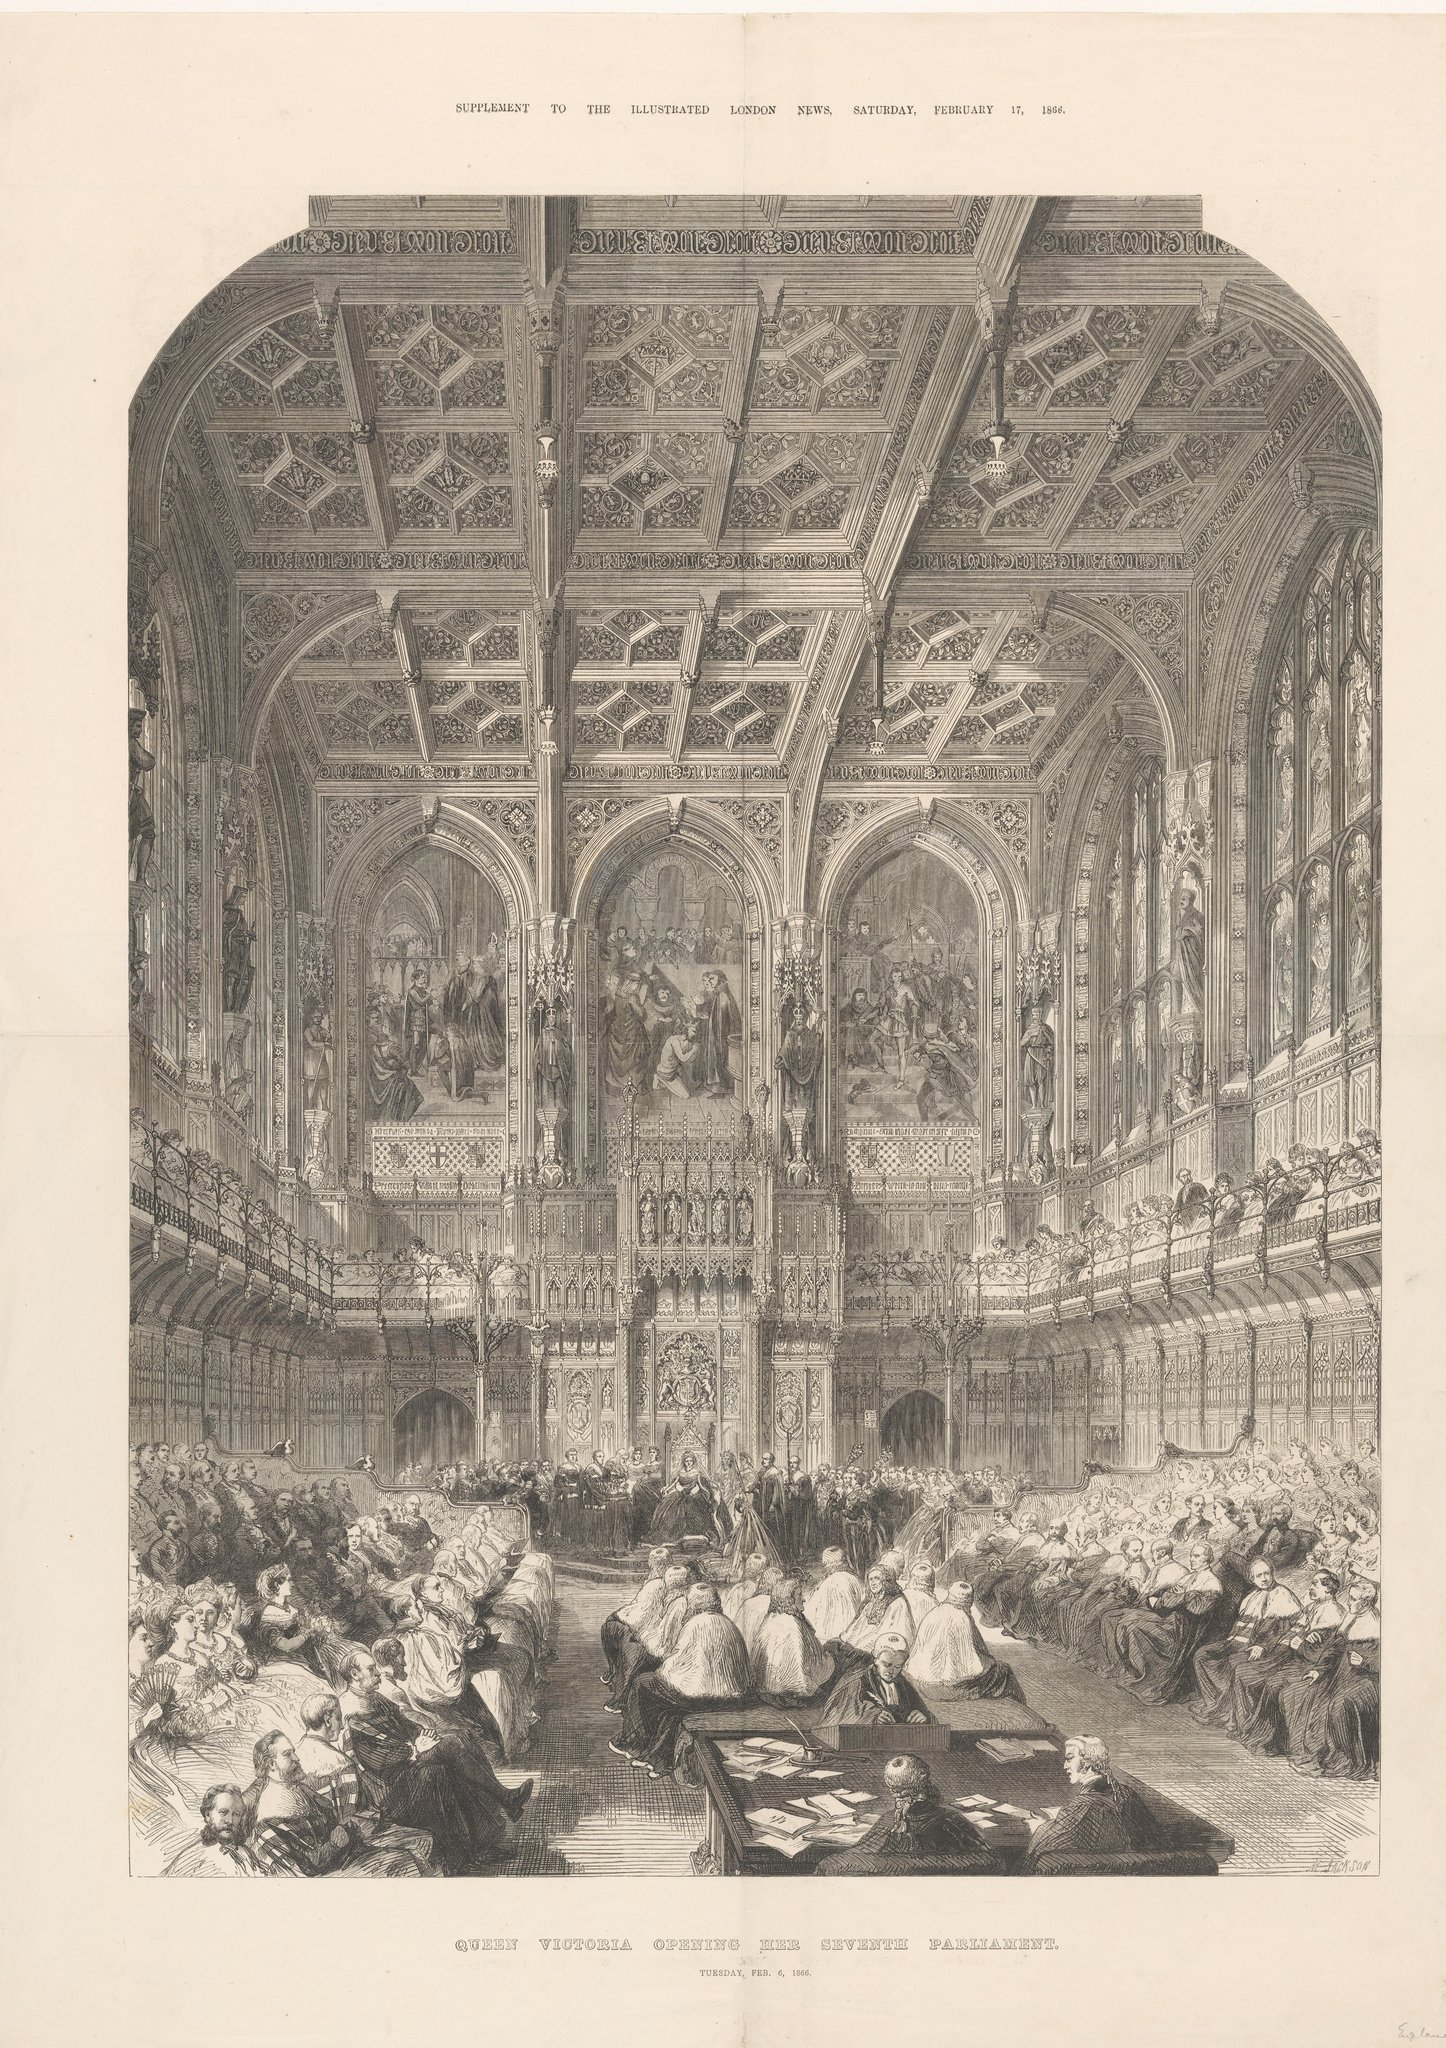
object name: book illustration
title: Koningin Victoria opent het parlement, 1866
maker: mason jackson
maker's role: print maker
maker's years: 1819-1903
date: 1802-1866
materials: paper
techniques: engraving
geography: england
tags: victoria (koningin van het verenigd koninkrijk en keizerin van india), official acts of rulers, e.g. royal acts (ruler giving audience, granting mercy, etc.; ruler and his subjects), upper house, senate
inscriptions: collector's mark: Lugt 2228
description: Koningin Victoria opent de zitting van het parlement, 6 februari 1866. Haar zevende parlement, bijeenkomst in het Britse Hogerhuis (House of Lords).